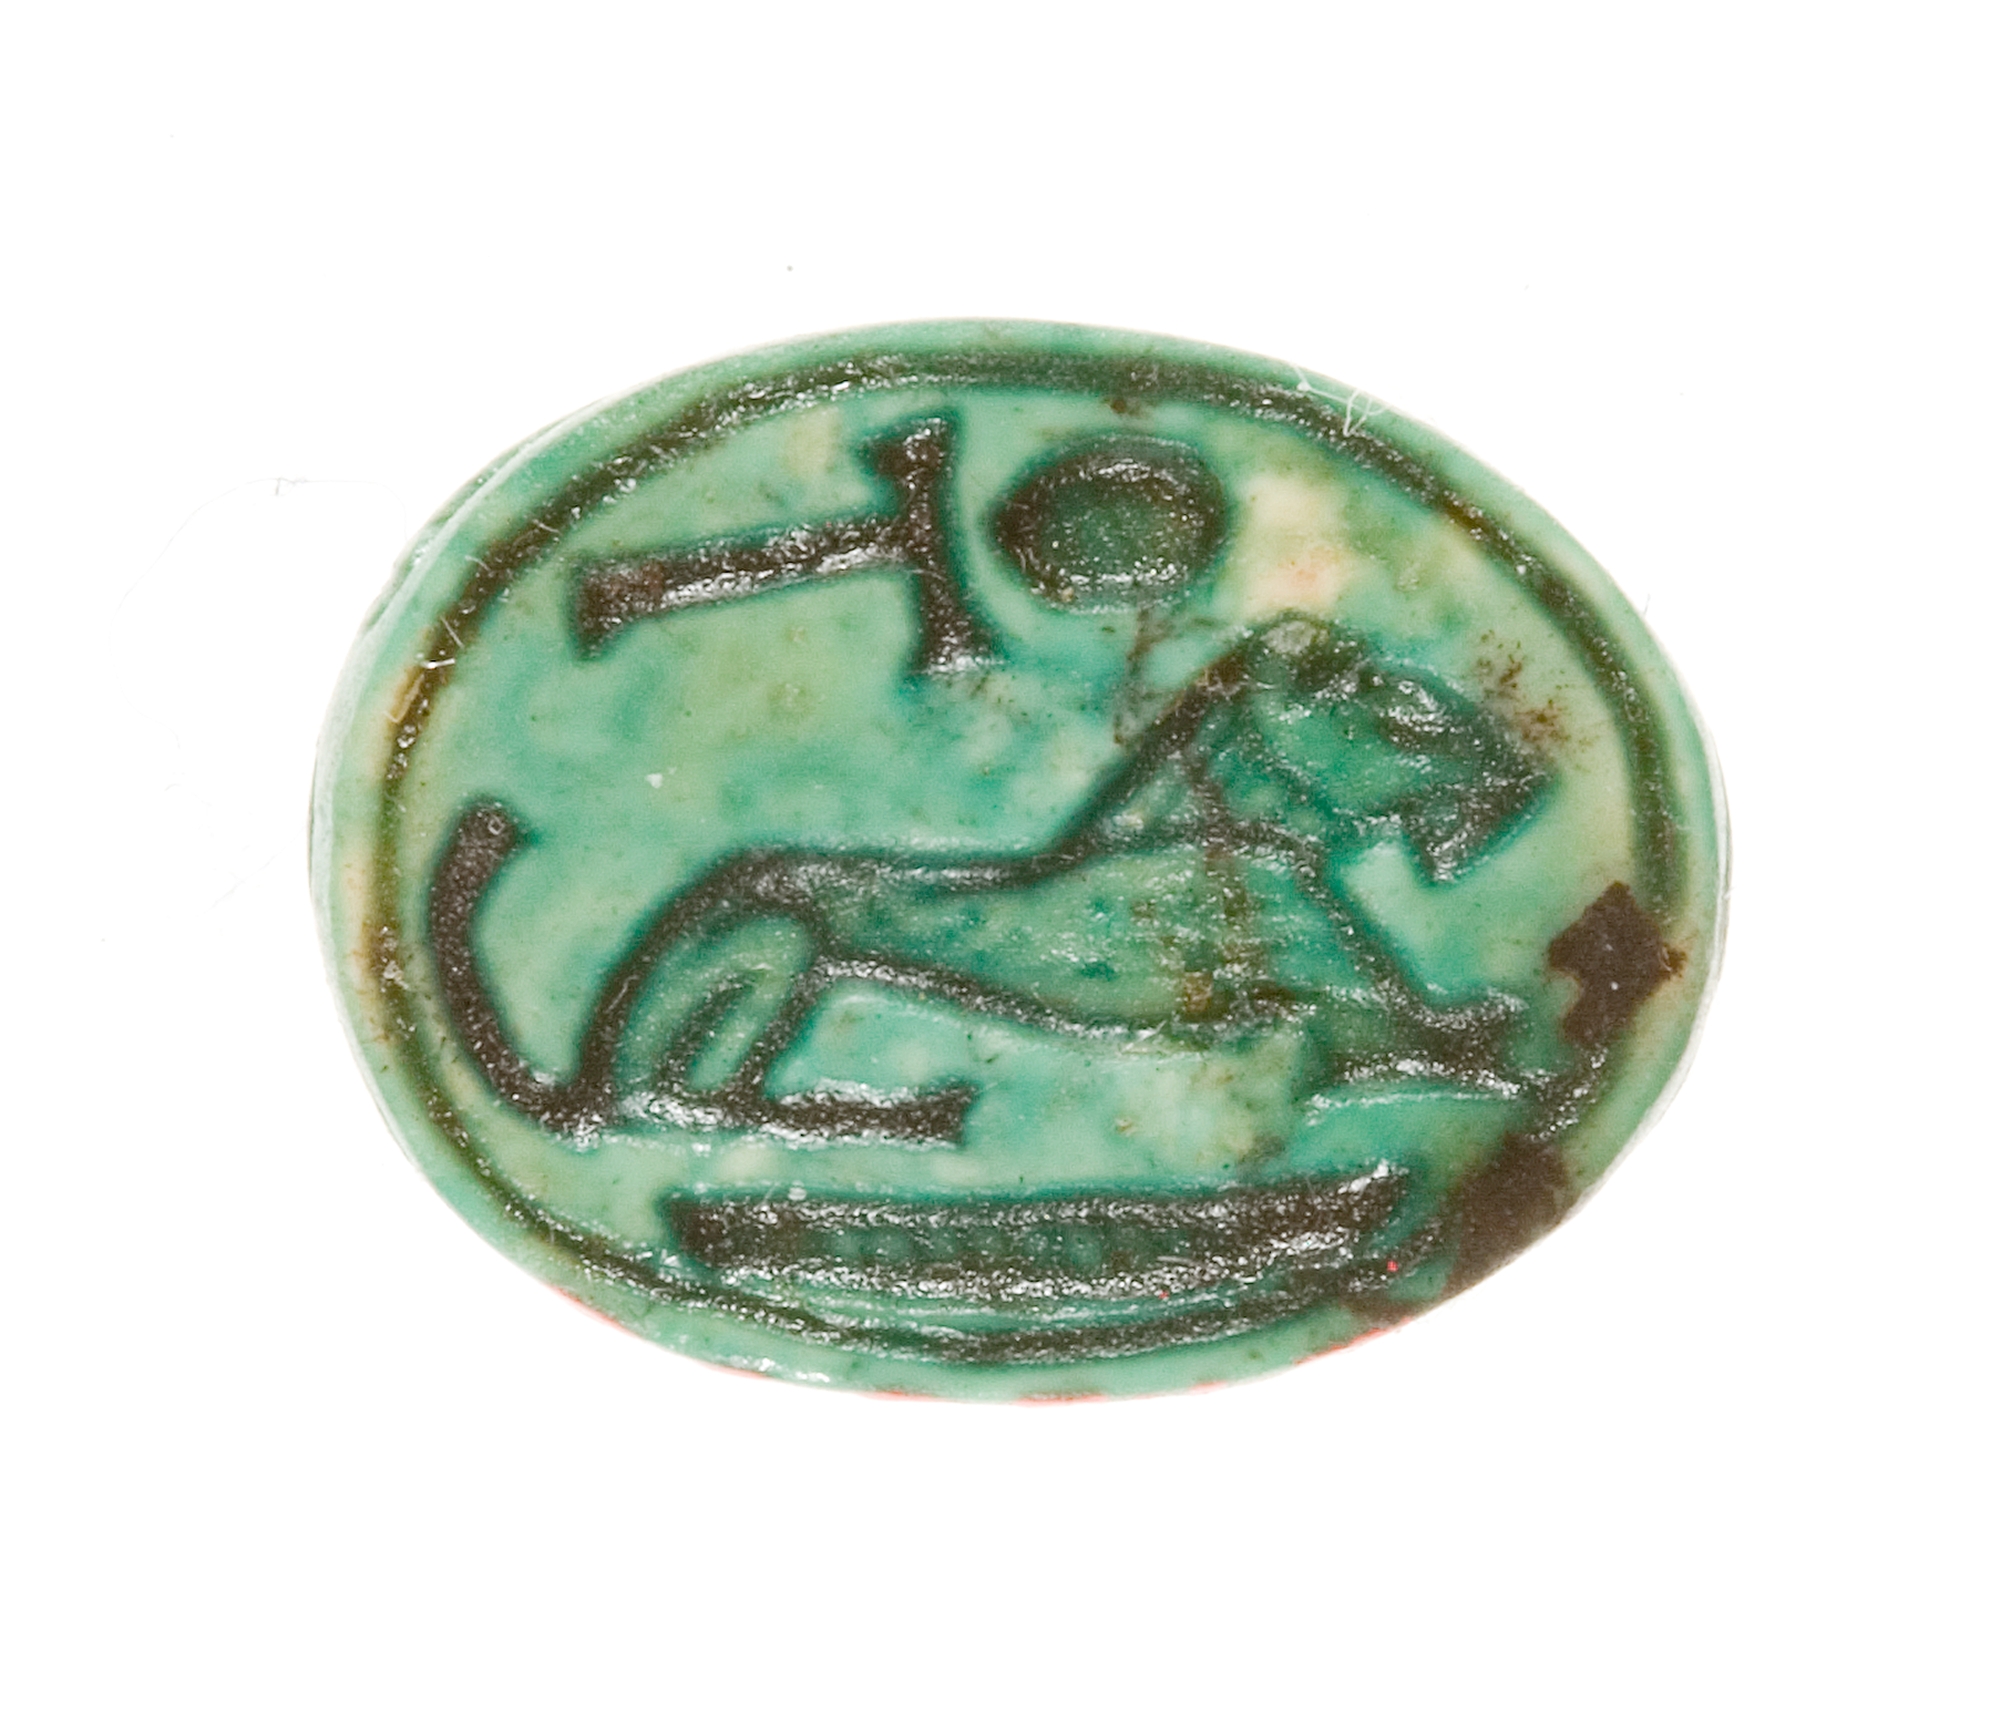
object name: scarab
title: Scarab Inscribed with a Hieroglyphic Motif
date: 1479-1458 BCE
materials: stone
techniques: glazing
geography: egypt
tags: hieroglyphs,scarabs